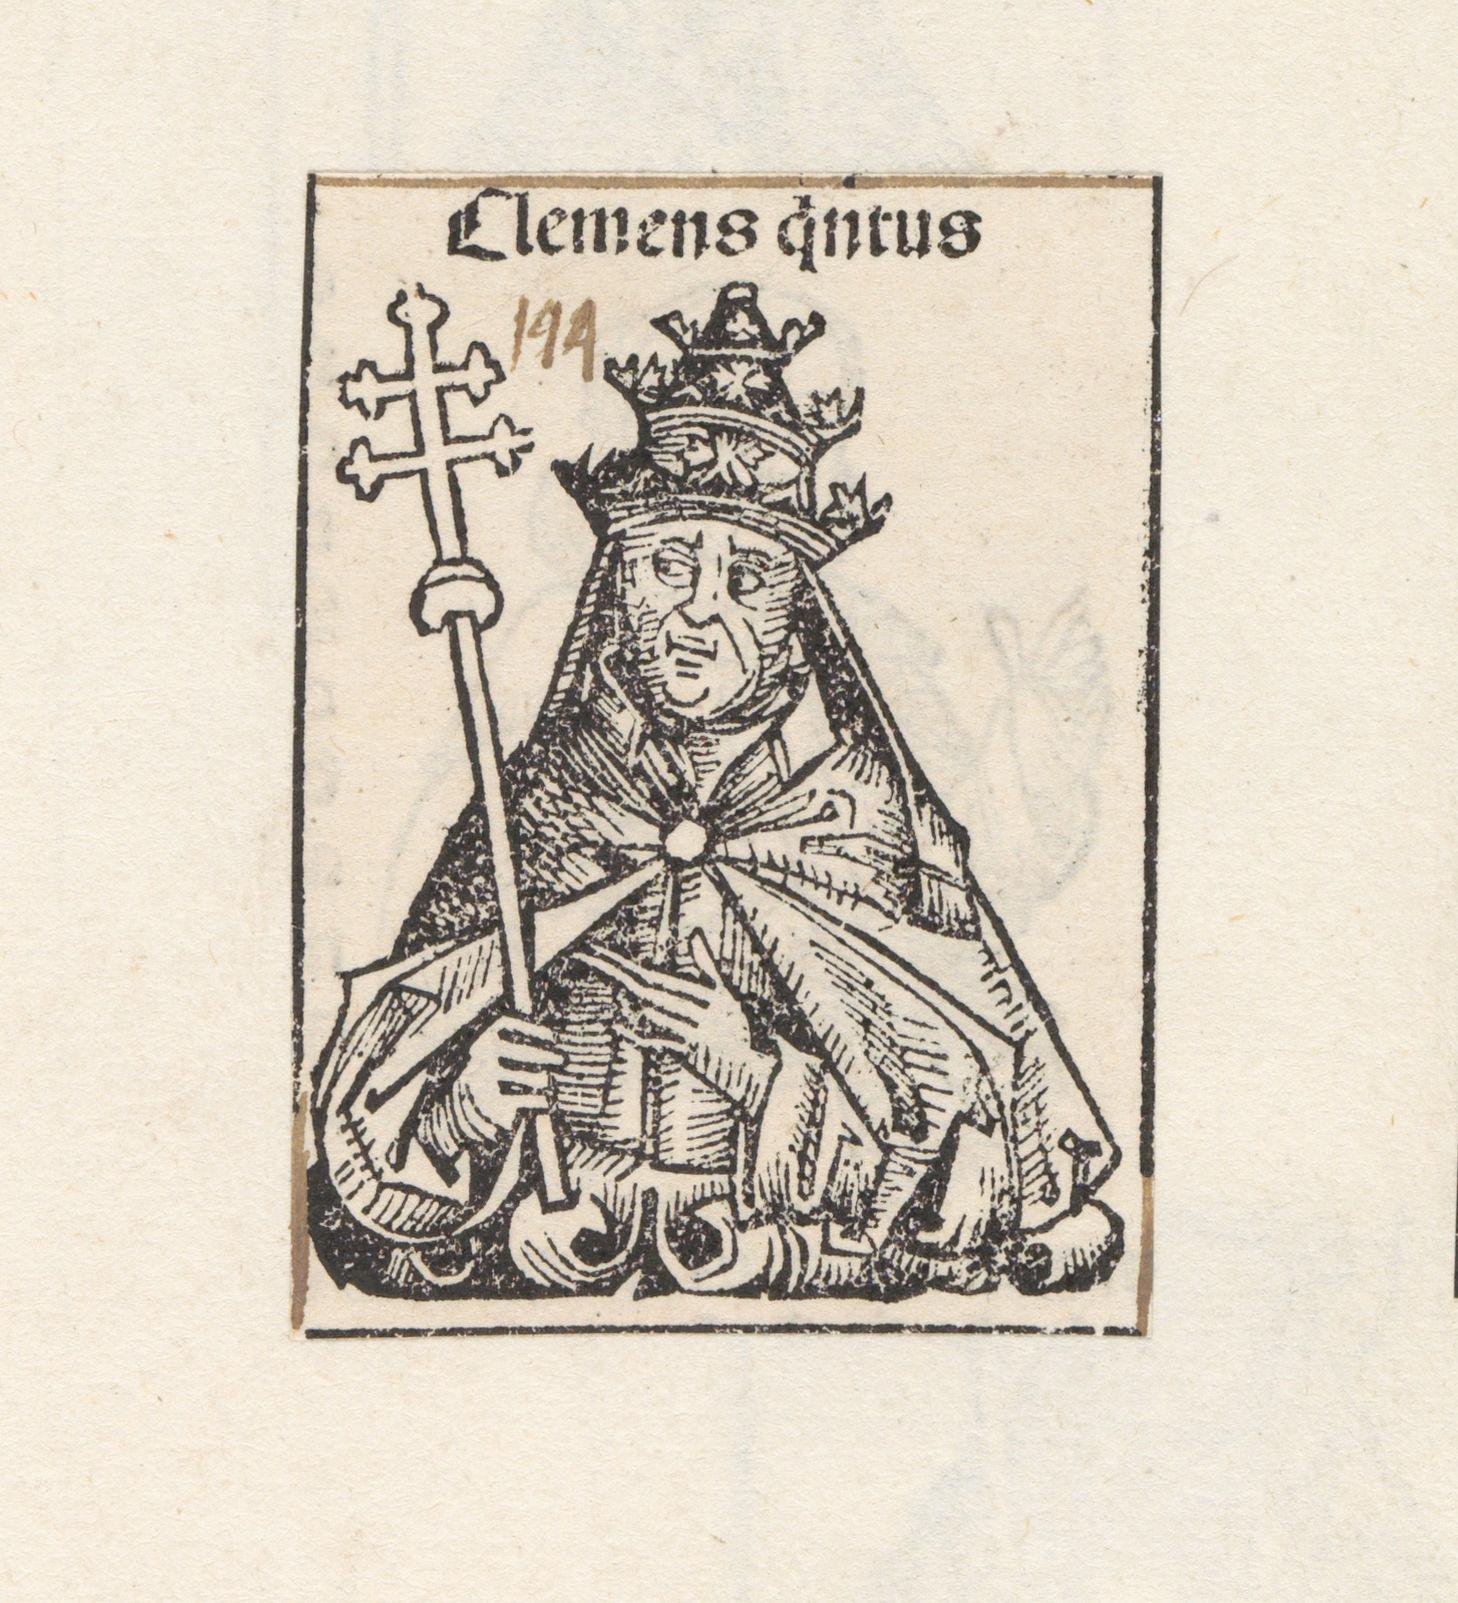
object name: album leaf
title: Liber Chronicarum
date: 1493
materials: paper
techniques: letterpress printing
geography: nuremberg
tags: pope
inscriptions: inscription: ‘144’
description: Een bloemkelk met een paus. Hij draagt een tiara en heeft een staf met dubbel kruis in zijn handen. De voorstelling is onderdeel van de opeenvolging pausen in de Liber Chronicarum. De tekst identificeert de man als Clemens V. De prent maakt deel uit van een album.